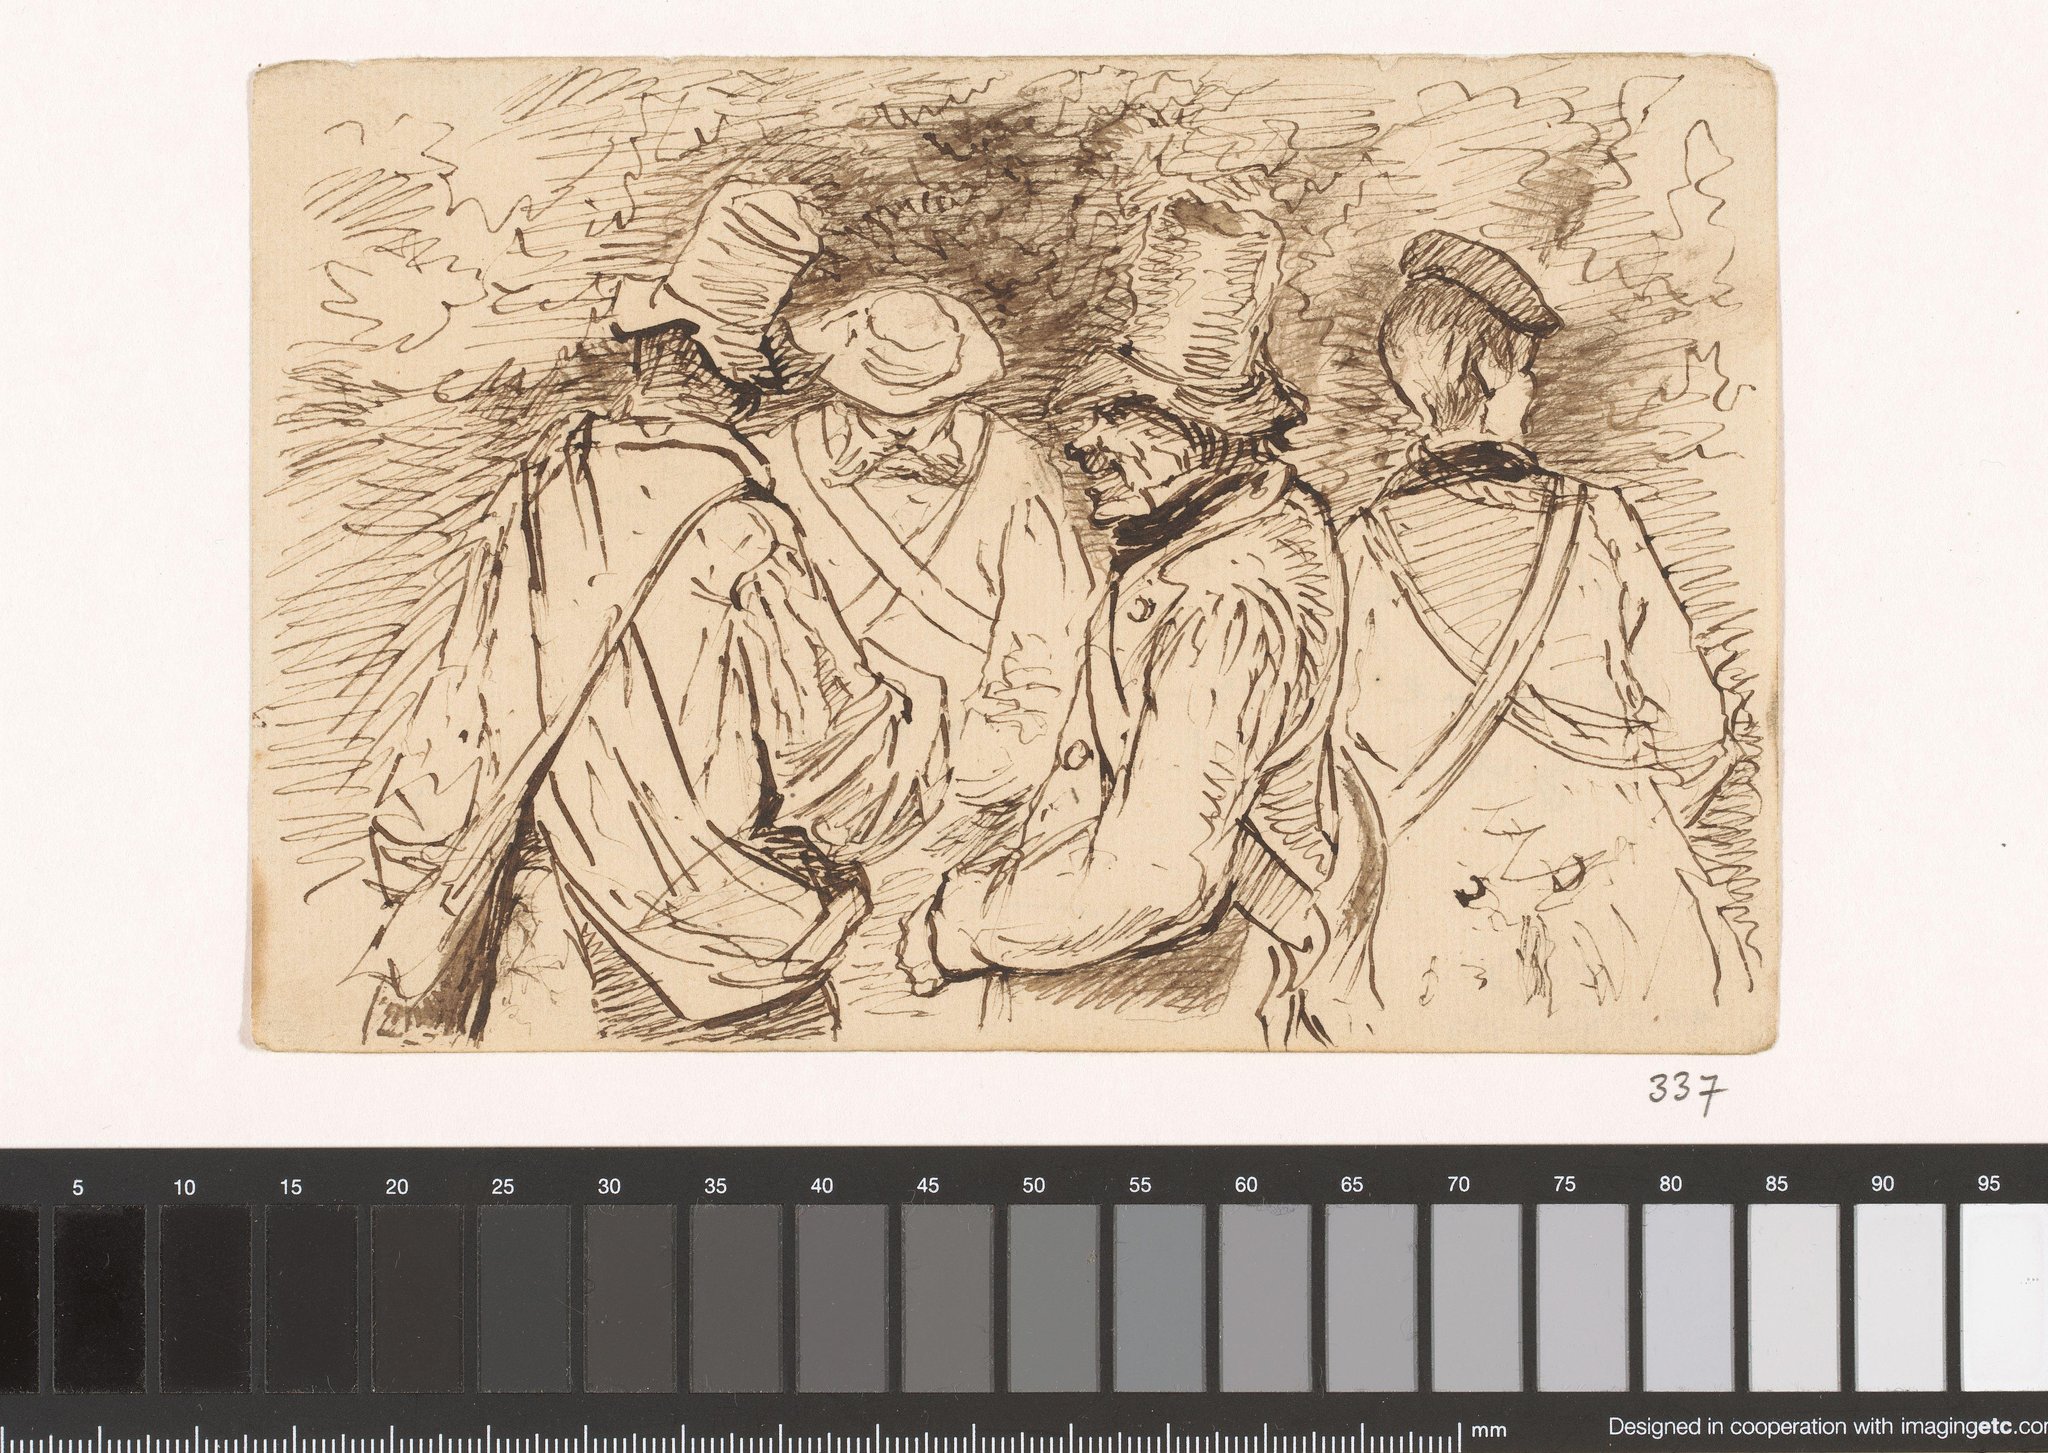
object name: drawing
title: Wachtende jagers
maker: johannes tavenraat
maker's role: draughtsman, painter, print maker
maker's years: 1809-1881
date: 1840-1880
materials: ink, paper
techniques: brush, pen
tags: assembling, 'départ pour la chasse'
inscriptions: signature: ‘Tavenraat / Wachtende jagers’, collector's mark: Lugt 2228